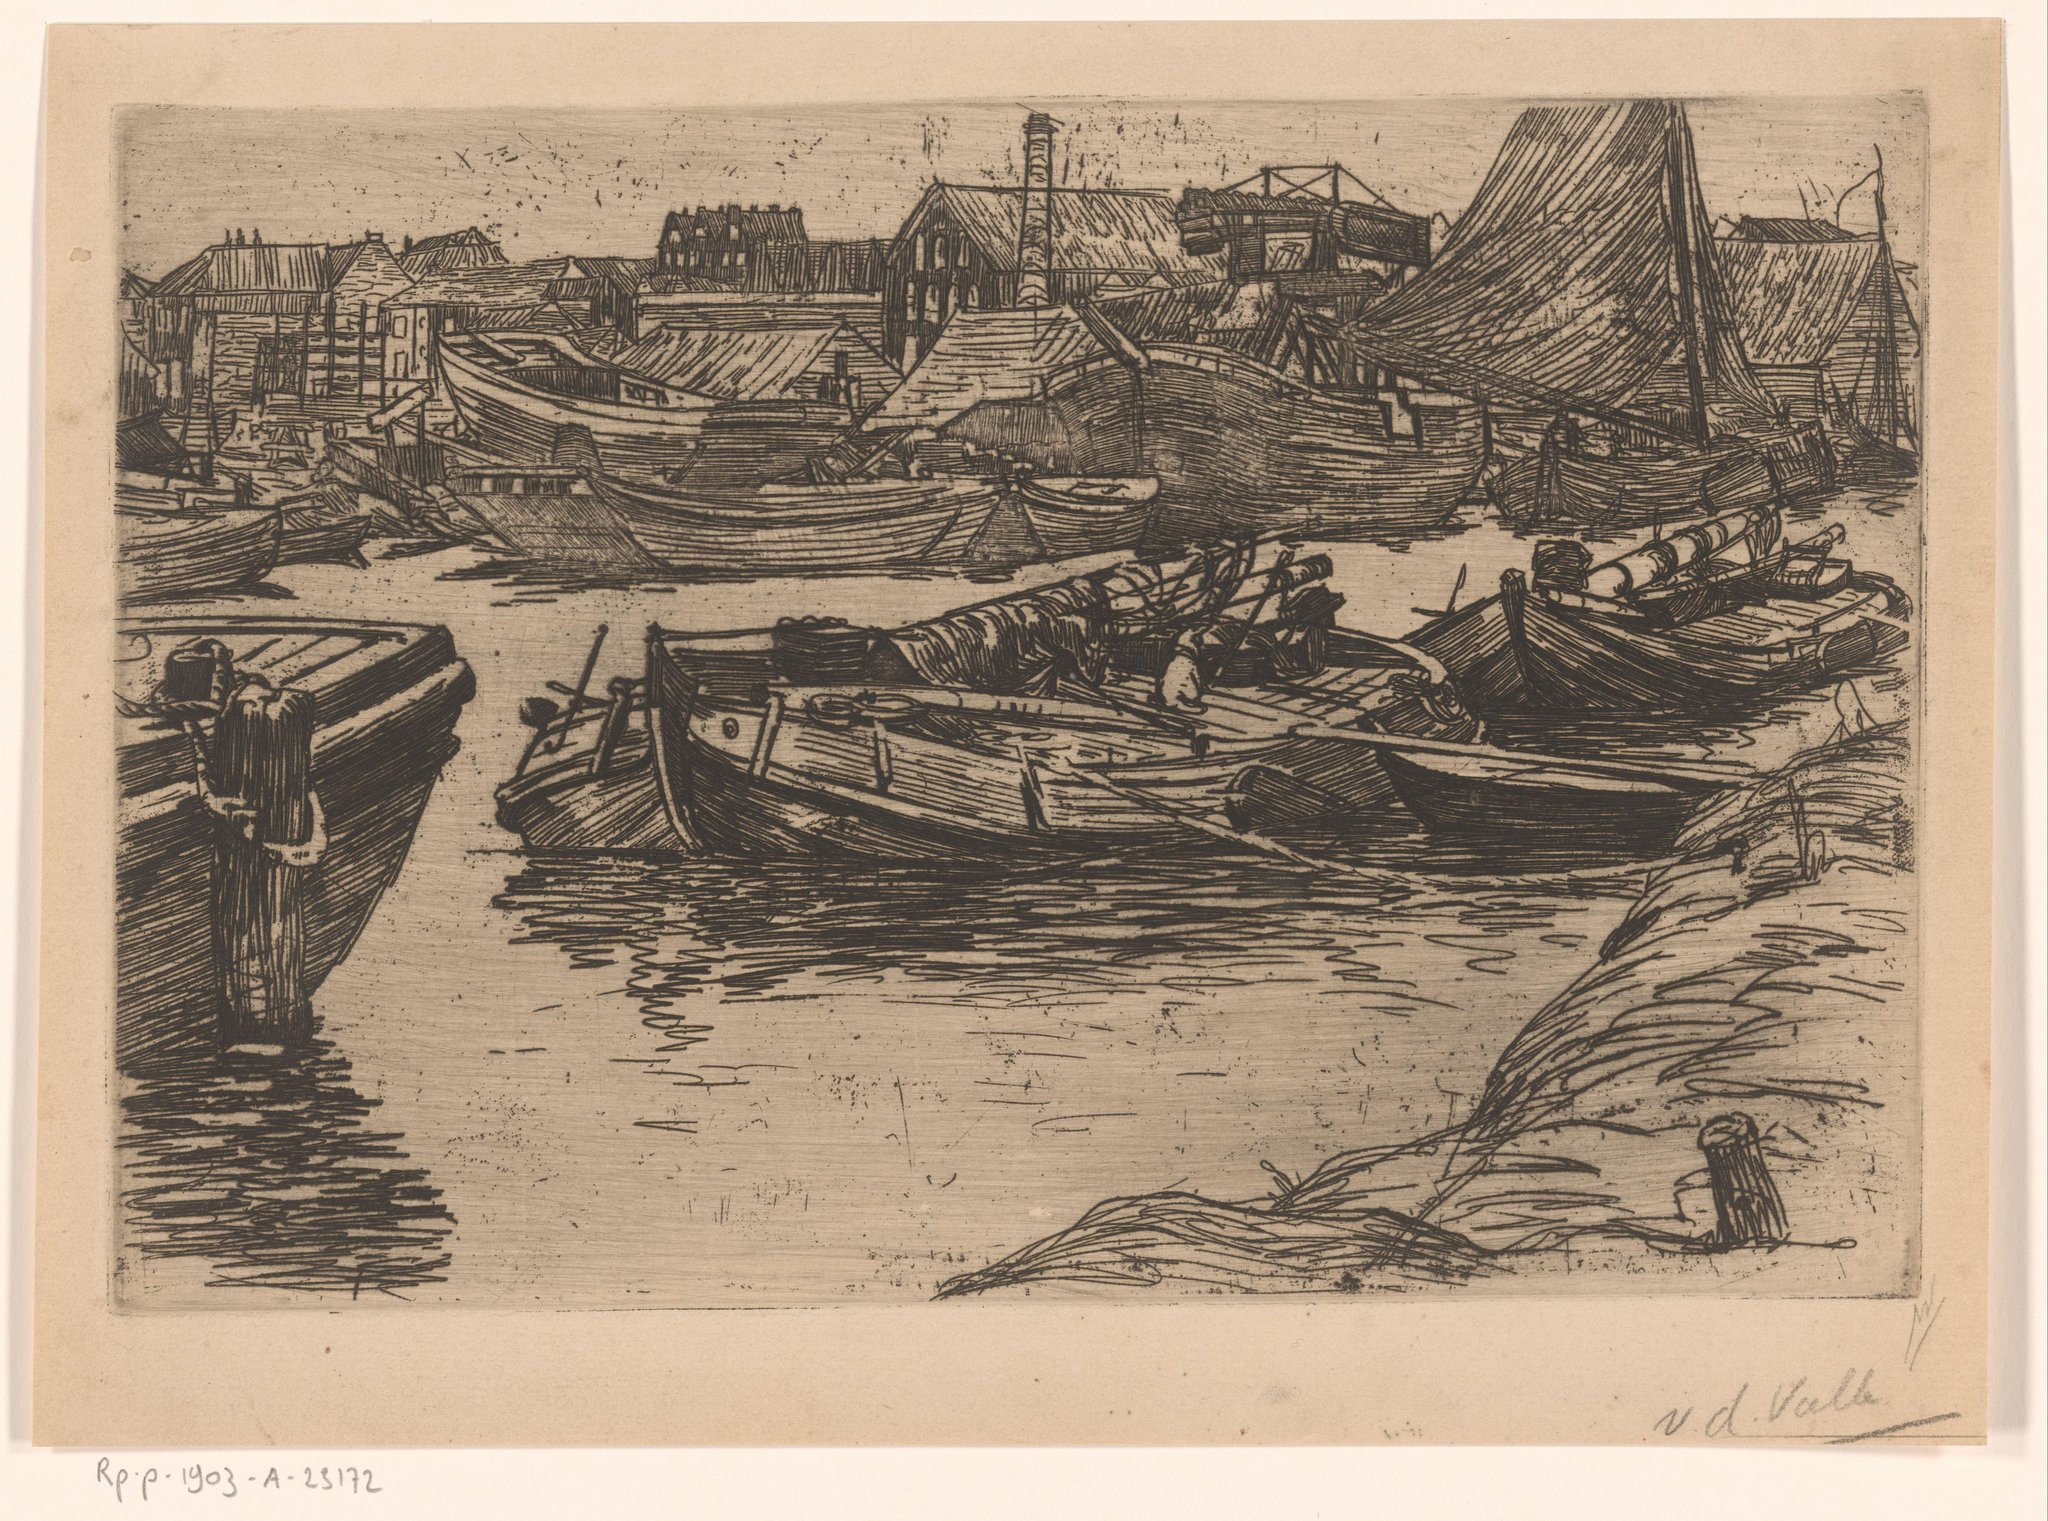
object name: print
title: Schepen aan de Schinkel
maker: maurits van der valk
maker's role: draughtsman, print maker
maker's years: 1857-1935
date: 1867-1903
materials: paper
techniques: drypoint, etching, intaglio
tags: harbour, sailing-ship, sailing-boat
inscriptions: collector's mark: Lugt 2228